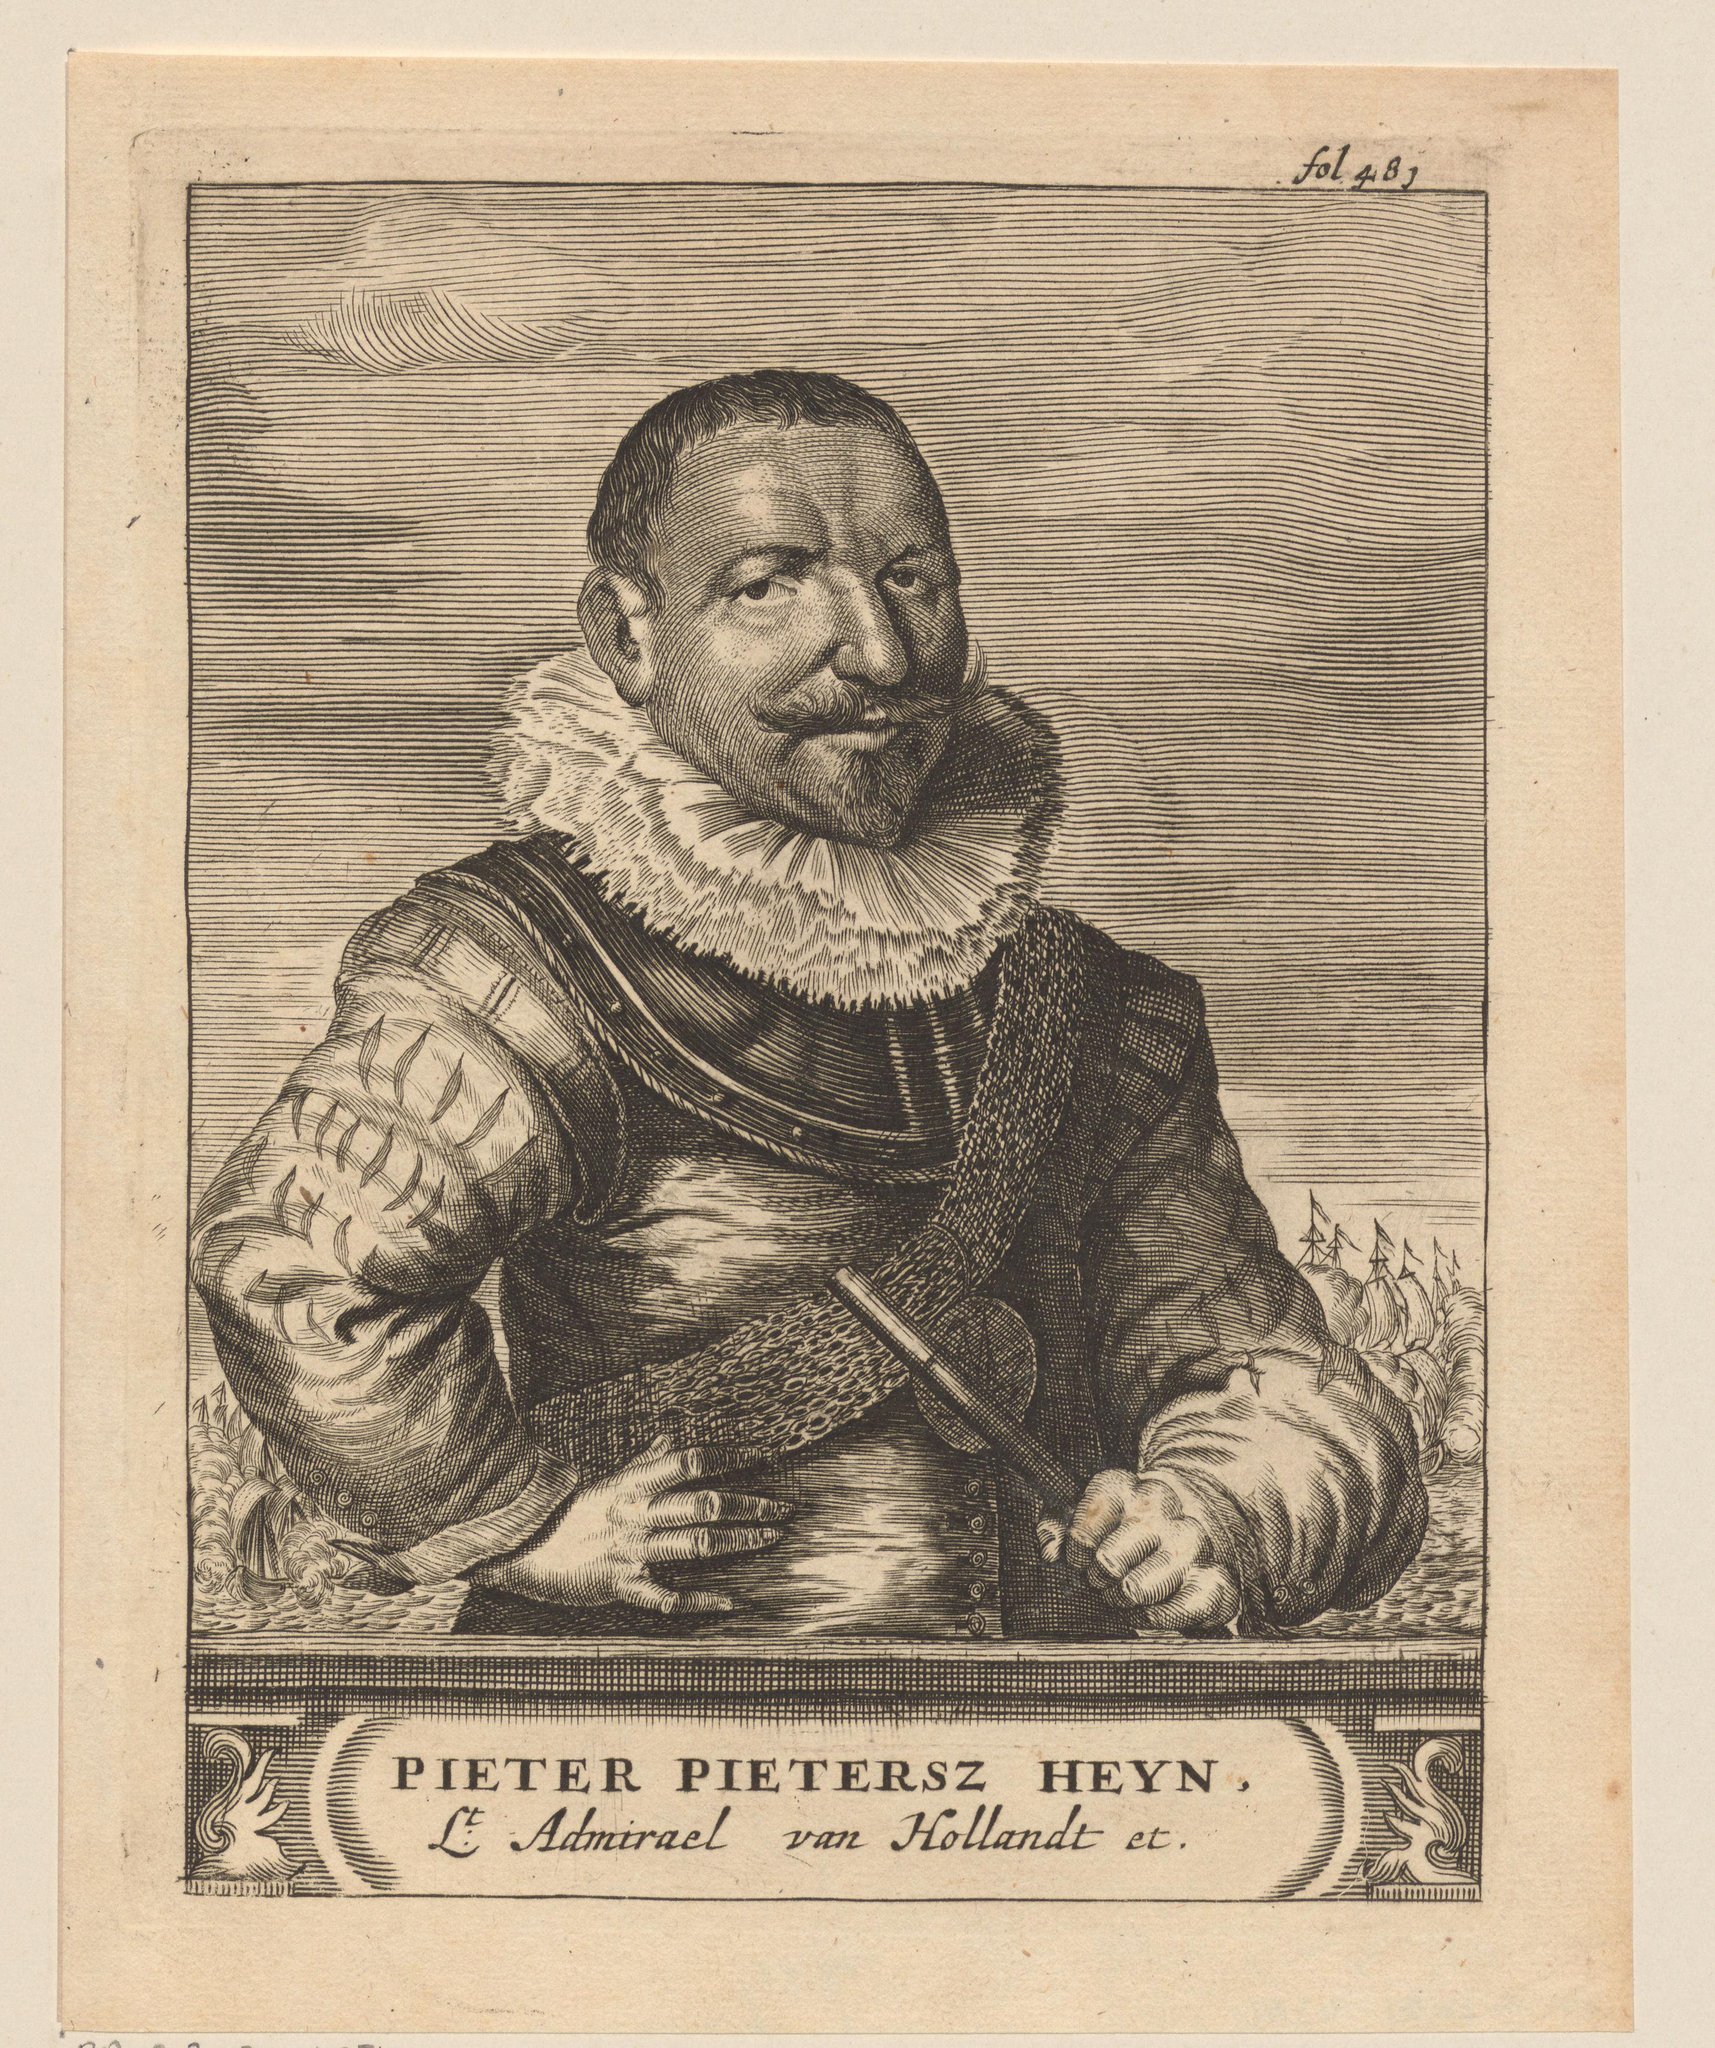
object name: print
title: Portret van Piet Hein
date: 1683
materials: paper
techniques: engraving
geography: amsterdam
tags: delfshaven, historical persons, commander-in-chief, admiral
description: Prent uit: Bos, Lambert van den. Leeven en daaden der doorluchtigste zee-helden. Amsterdam: Jan Claesz. ten Hoorn en Jan Bouman, 1683. Eerdere staat gebruikt in de eerste editie van dit werk, uitgegeven in 1676.